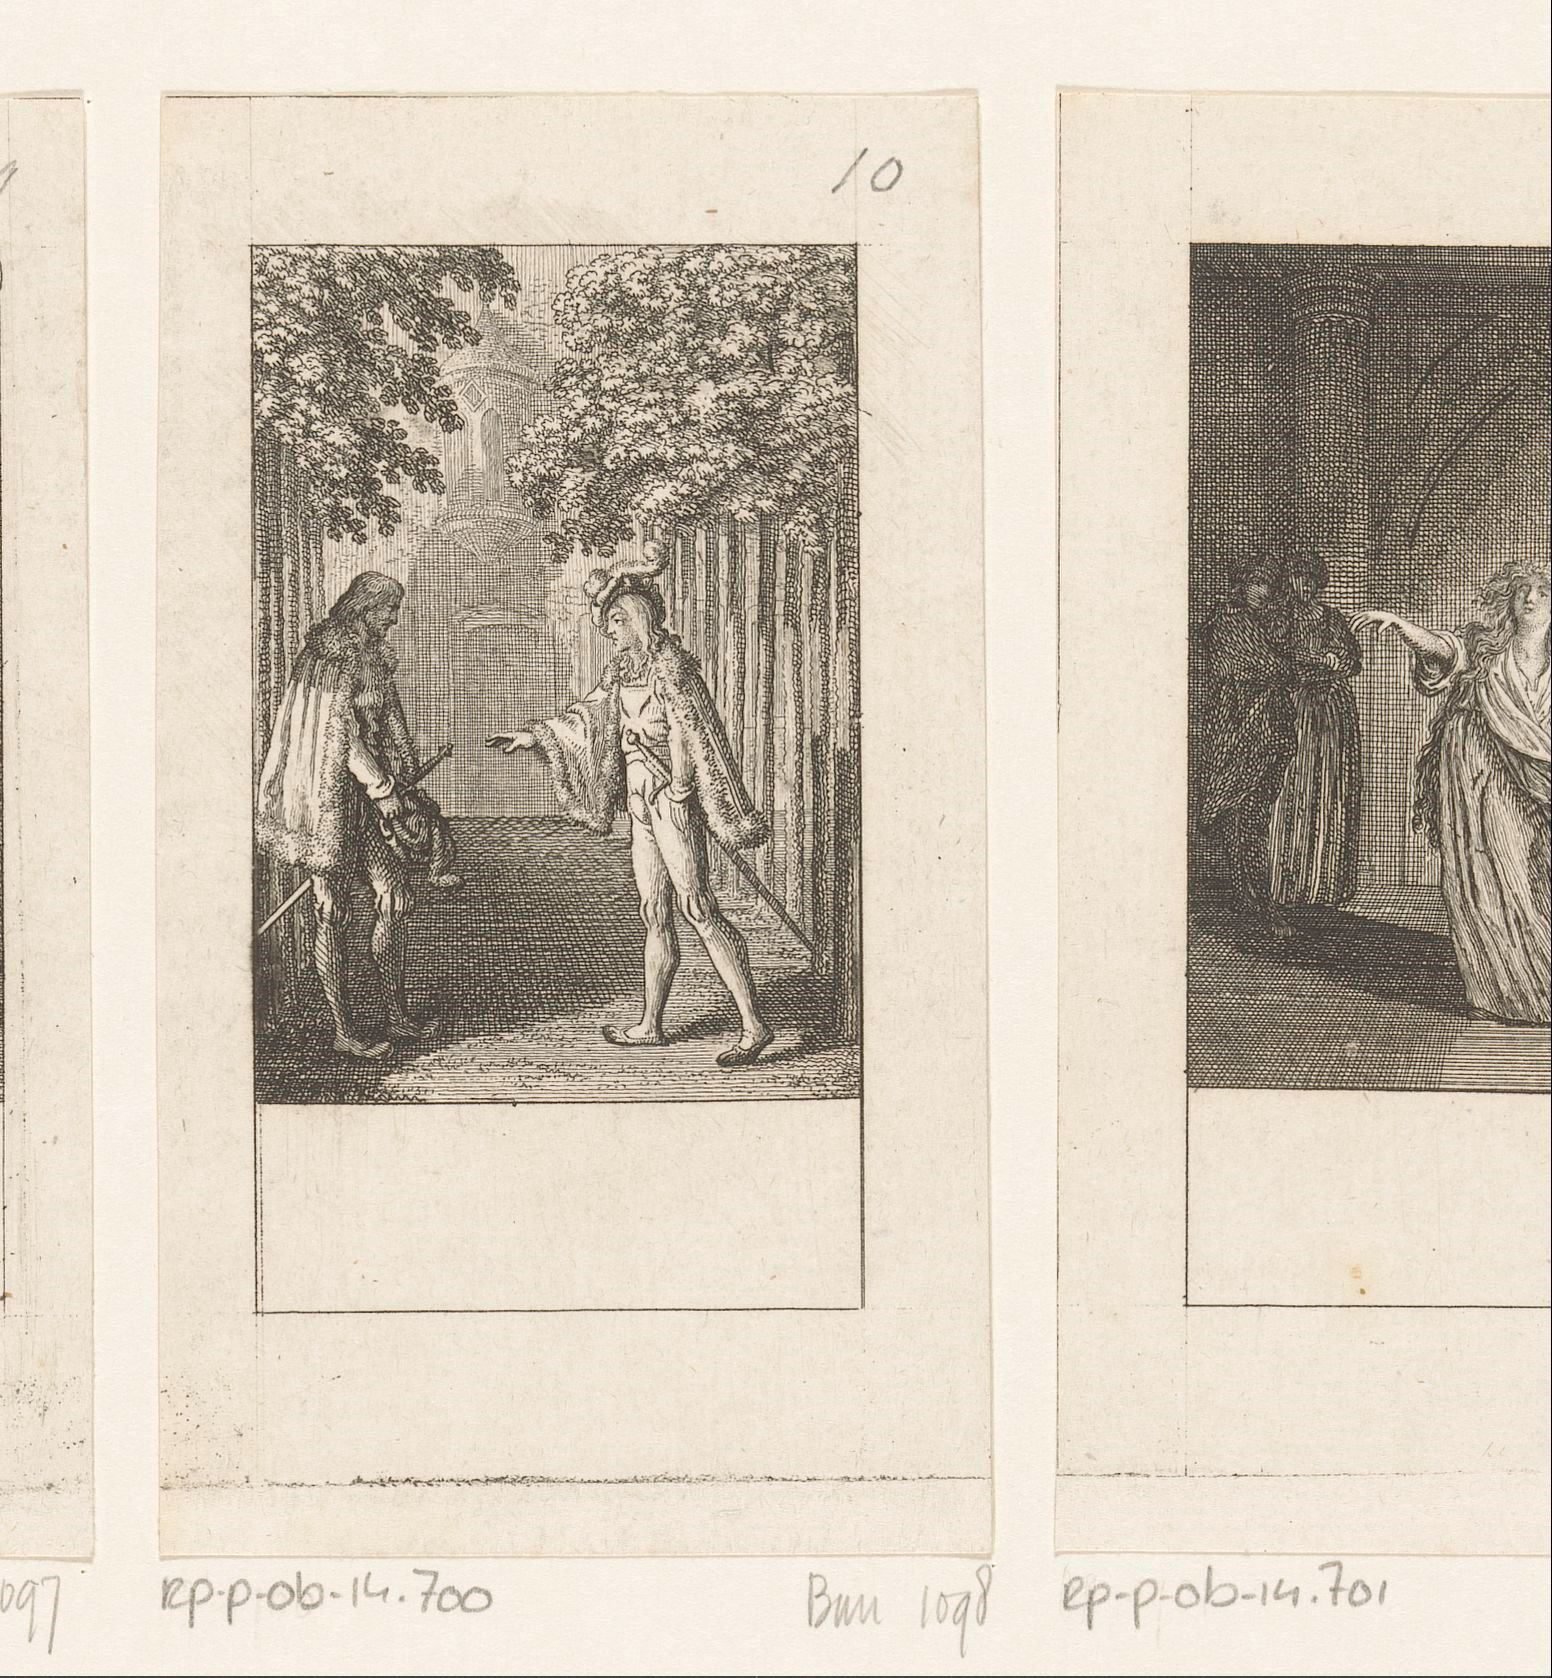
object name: print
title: Malcolm en Macduff besluiten samen te vechten tegen Macbeth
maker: daniel nikolaus chodowiecki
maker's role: draughtsman, print maker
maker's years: 1726-1801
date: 1784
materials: paper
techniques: etching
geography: berlin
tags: william shakespeare, (revolutionary) plot, conspiracy, literature, macbeth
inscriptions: collector's mark: Lugt 2228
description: Vervaardigd voor William Shakespeares 'Macbeth'. Latere staat gebruikt voor: Goettinger Taschen Calender vom Jahre 1785. Göttingen: Johann Christoph Dietrich, 1784.